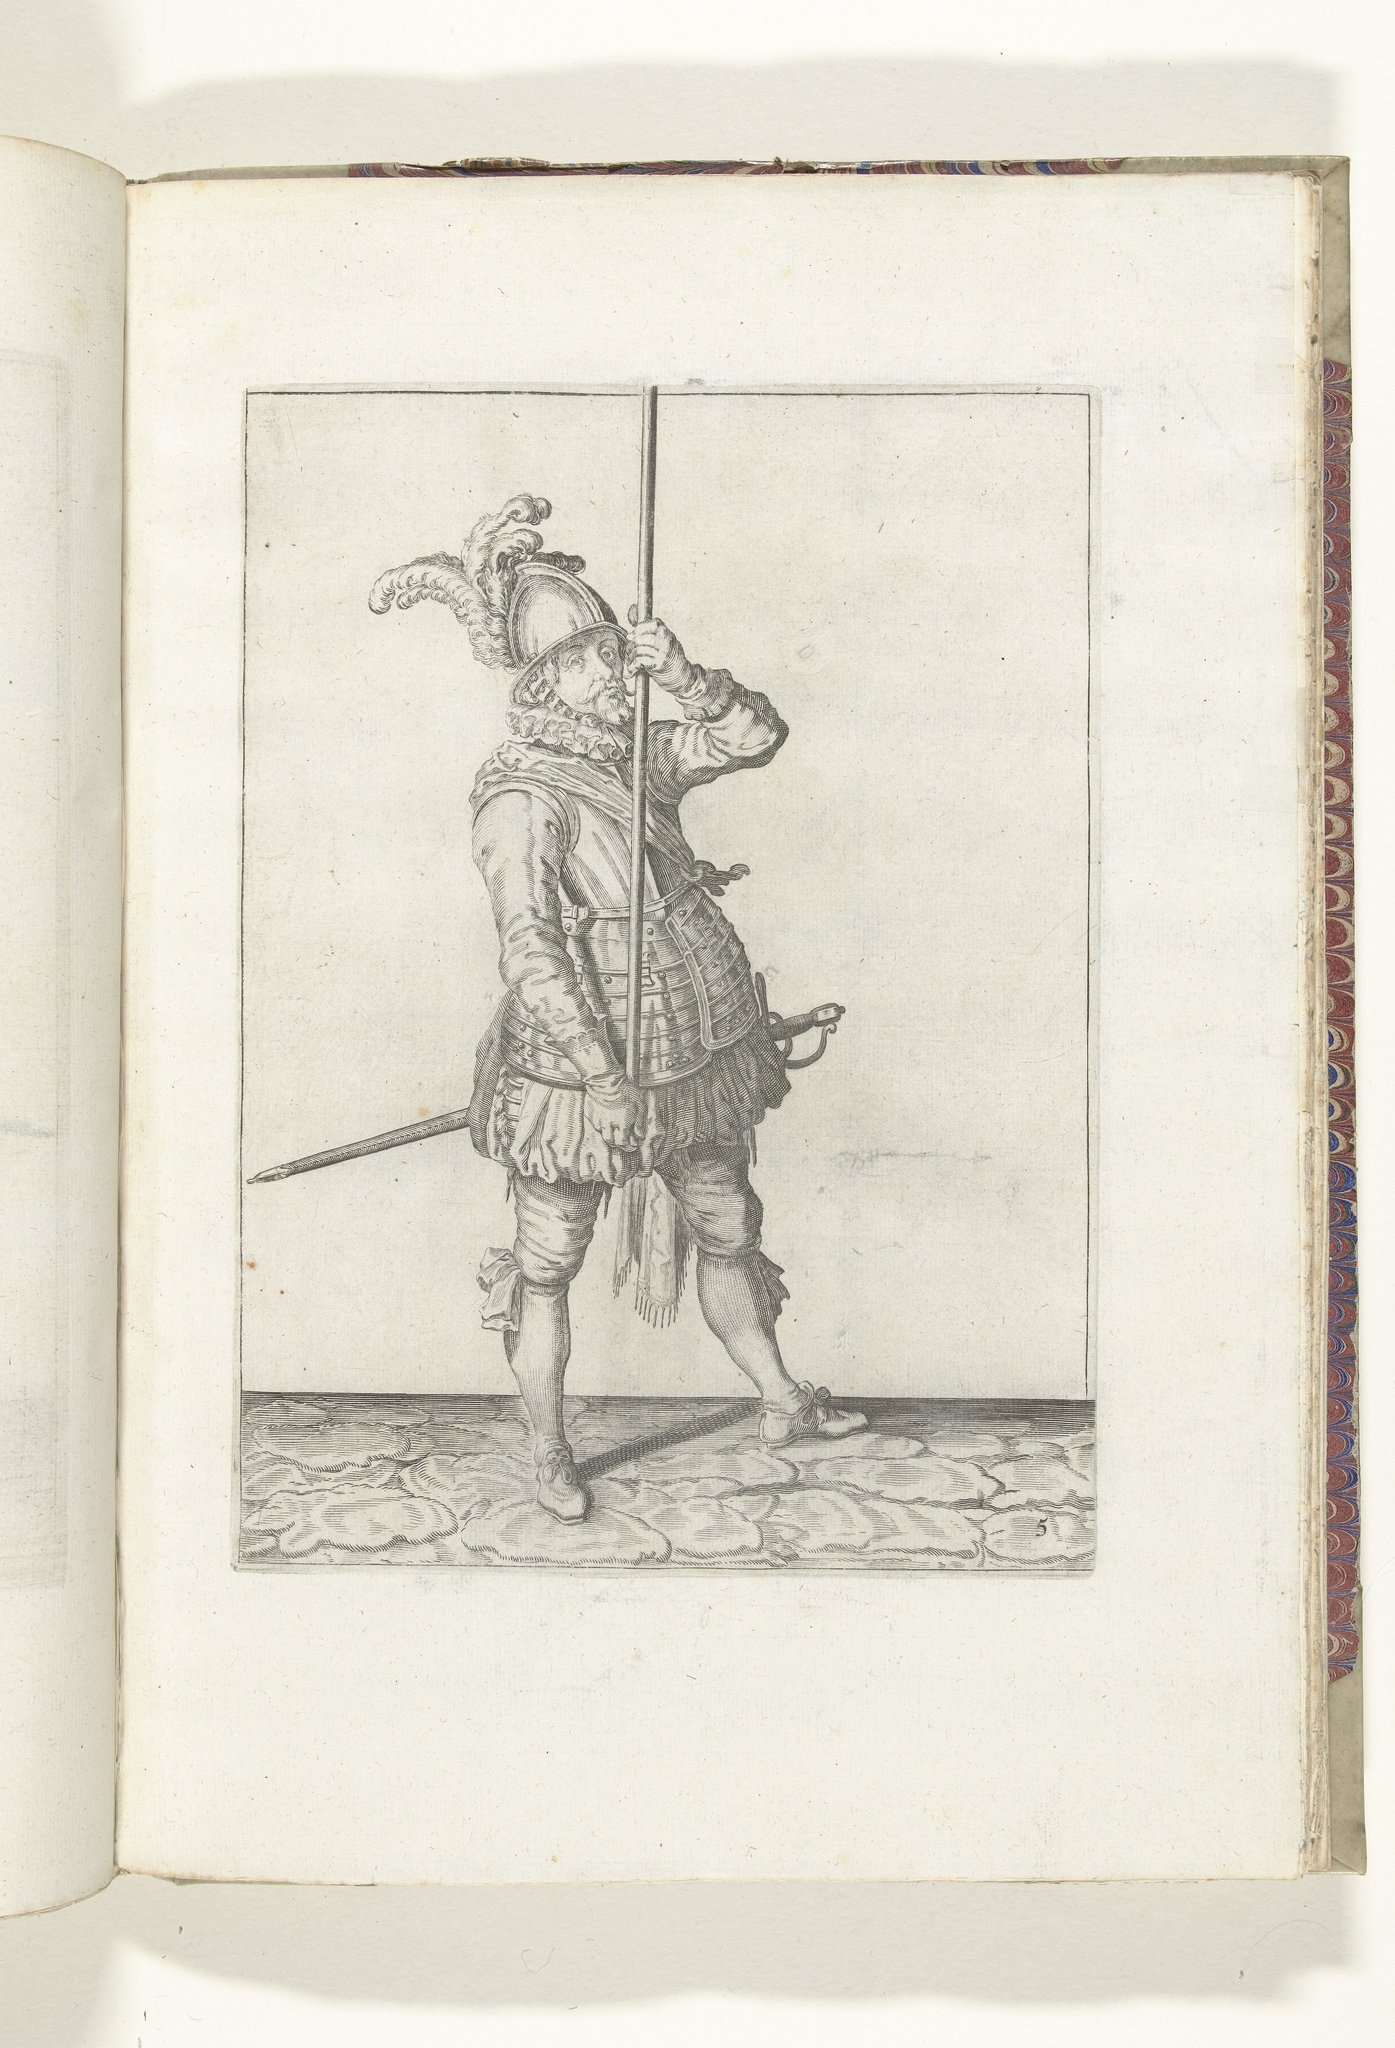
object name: print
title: Soldaat die zijn spies met beide handen rechtop voor zich hoog boven de grond vasthoudt (nr. 5), ca. 1600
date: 1597-1607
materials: paper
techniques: engraving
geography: amsterdam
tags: the hague, maurice (prince of orange), handling of weapons ~ military training, weapons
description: Een soldaat, ten voeten uit, naar rechts, die een spies (lans) met beide handen rechtop voor zich hoog boven de grond vasthoudt (nr. 5), ca. 1600. Dit is de eerste handeling voor het rechtop naar de grond brengen van de spies. Plaat 5 in de instructies voor het hanteren van de spies: Corte onderwysinghe op de figuerliicke afbeeldinghe belanghende trechte gebruck, van alle t'ghene een Soldaet int handelen vande Spies noodich is. Onderdeel van de illustraties in: J. de Gheyn, Wapenhandelinghe van Roers Musquetten ende spiessen, Amsterdam, 1608. Krijgswezen rond 1600.